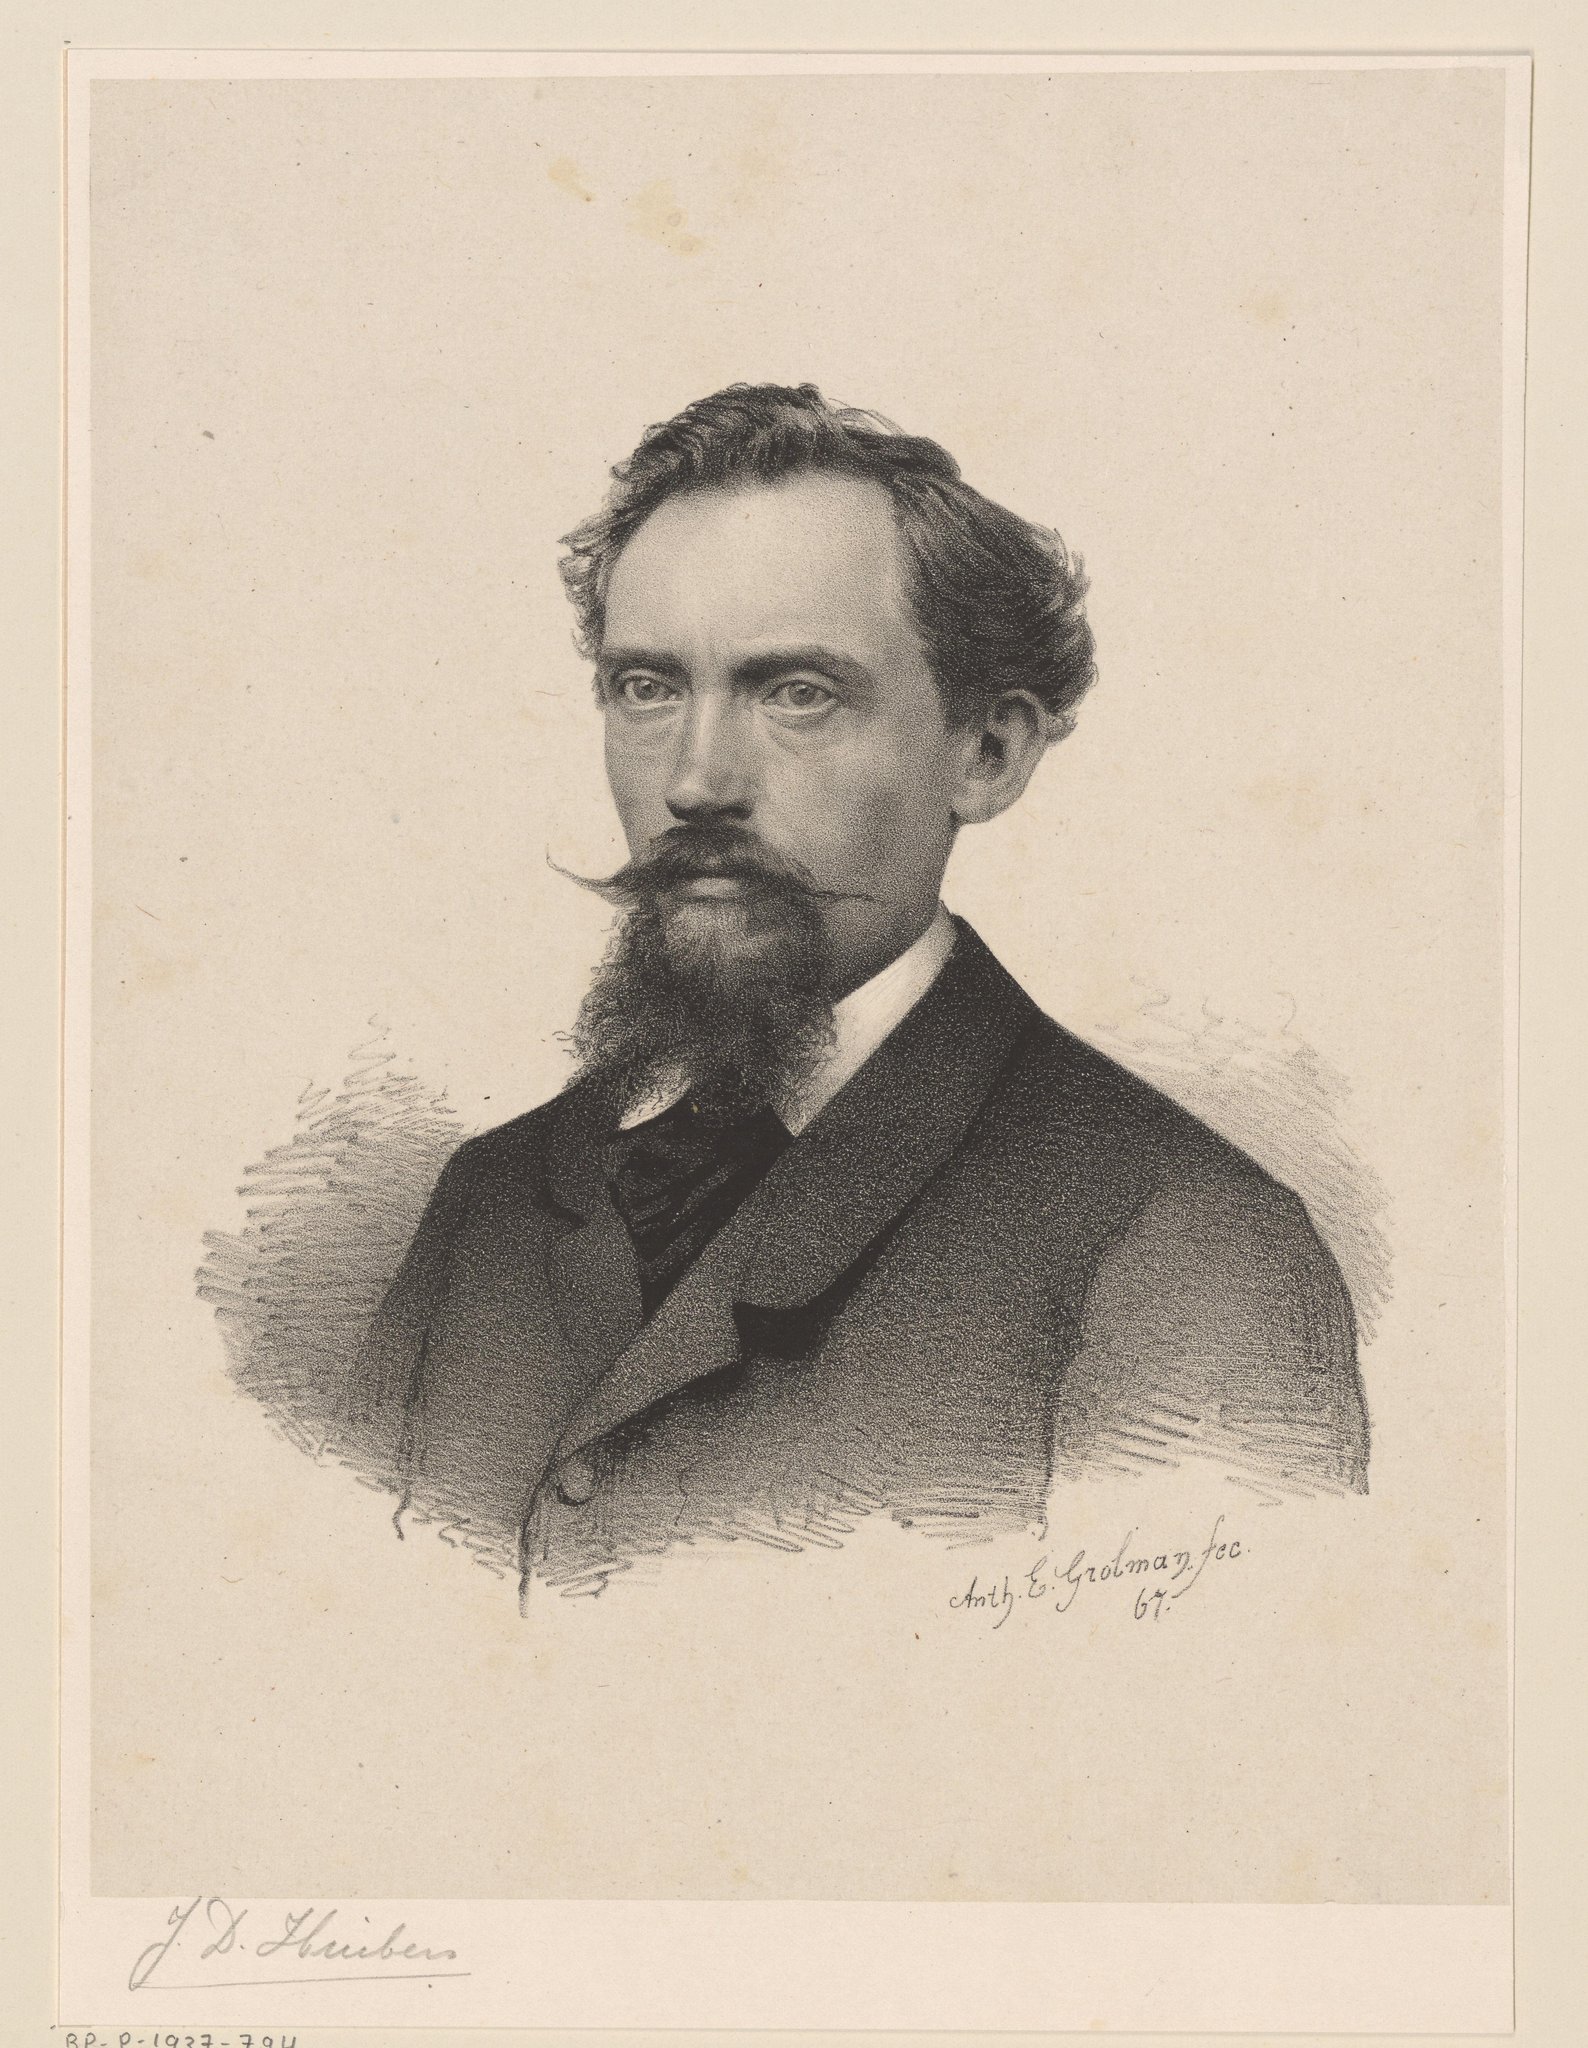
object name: print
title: Portret van Jan Derk Huibers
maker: anthony grolman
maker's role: draughtsman, print maker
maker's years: 1843-1926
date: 1867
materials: paper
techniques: lithograph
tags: painter, jan derk huibers, historical persons, portrait, self-portrait of painter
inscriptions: collector's mark: Lugt 2228, collector's mark: Lugt 2760